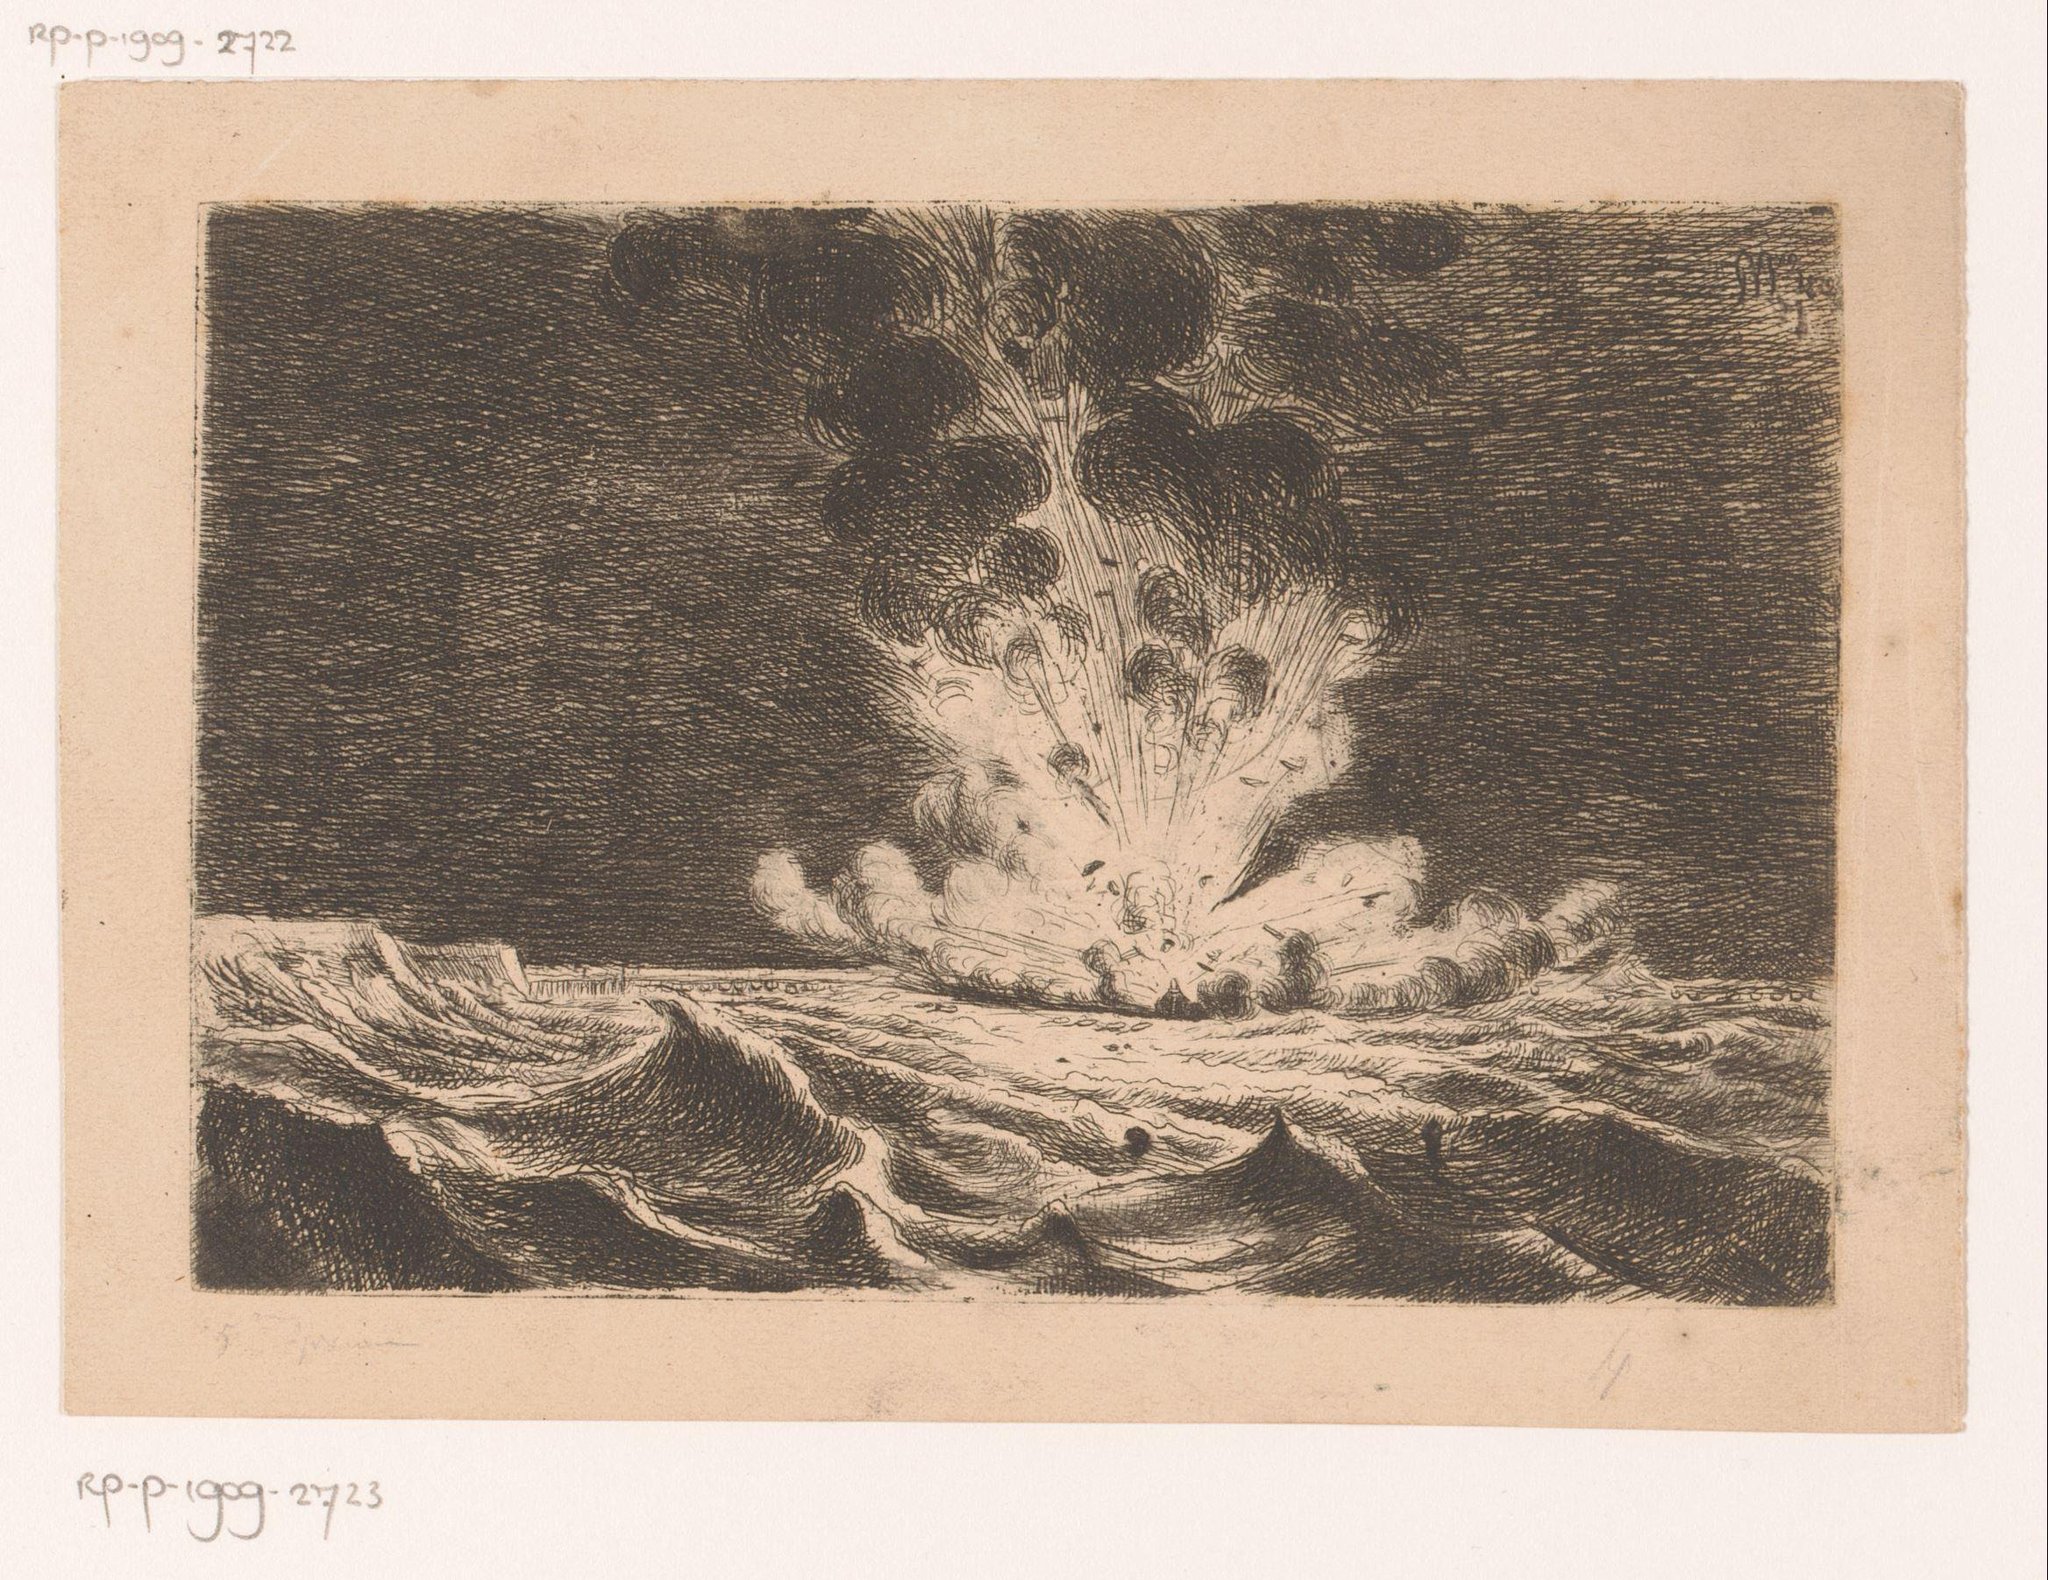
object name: print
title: Parma's brug bij Antwerpen door een brander opgeblazen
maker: gustave buschmann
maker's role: print maker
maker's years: 1818-1852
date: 1842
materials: paper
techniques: etching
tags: pontoon bridge, projectiles, explosives, etc., antwerp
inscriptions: collector's mark: Lugt 1485, collector's mark: Lugt 2228